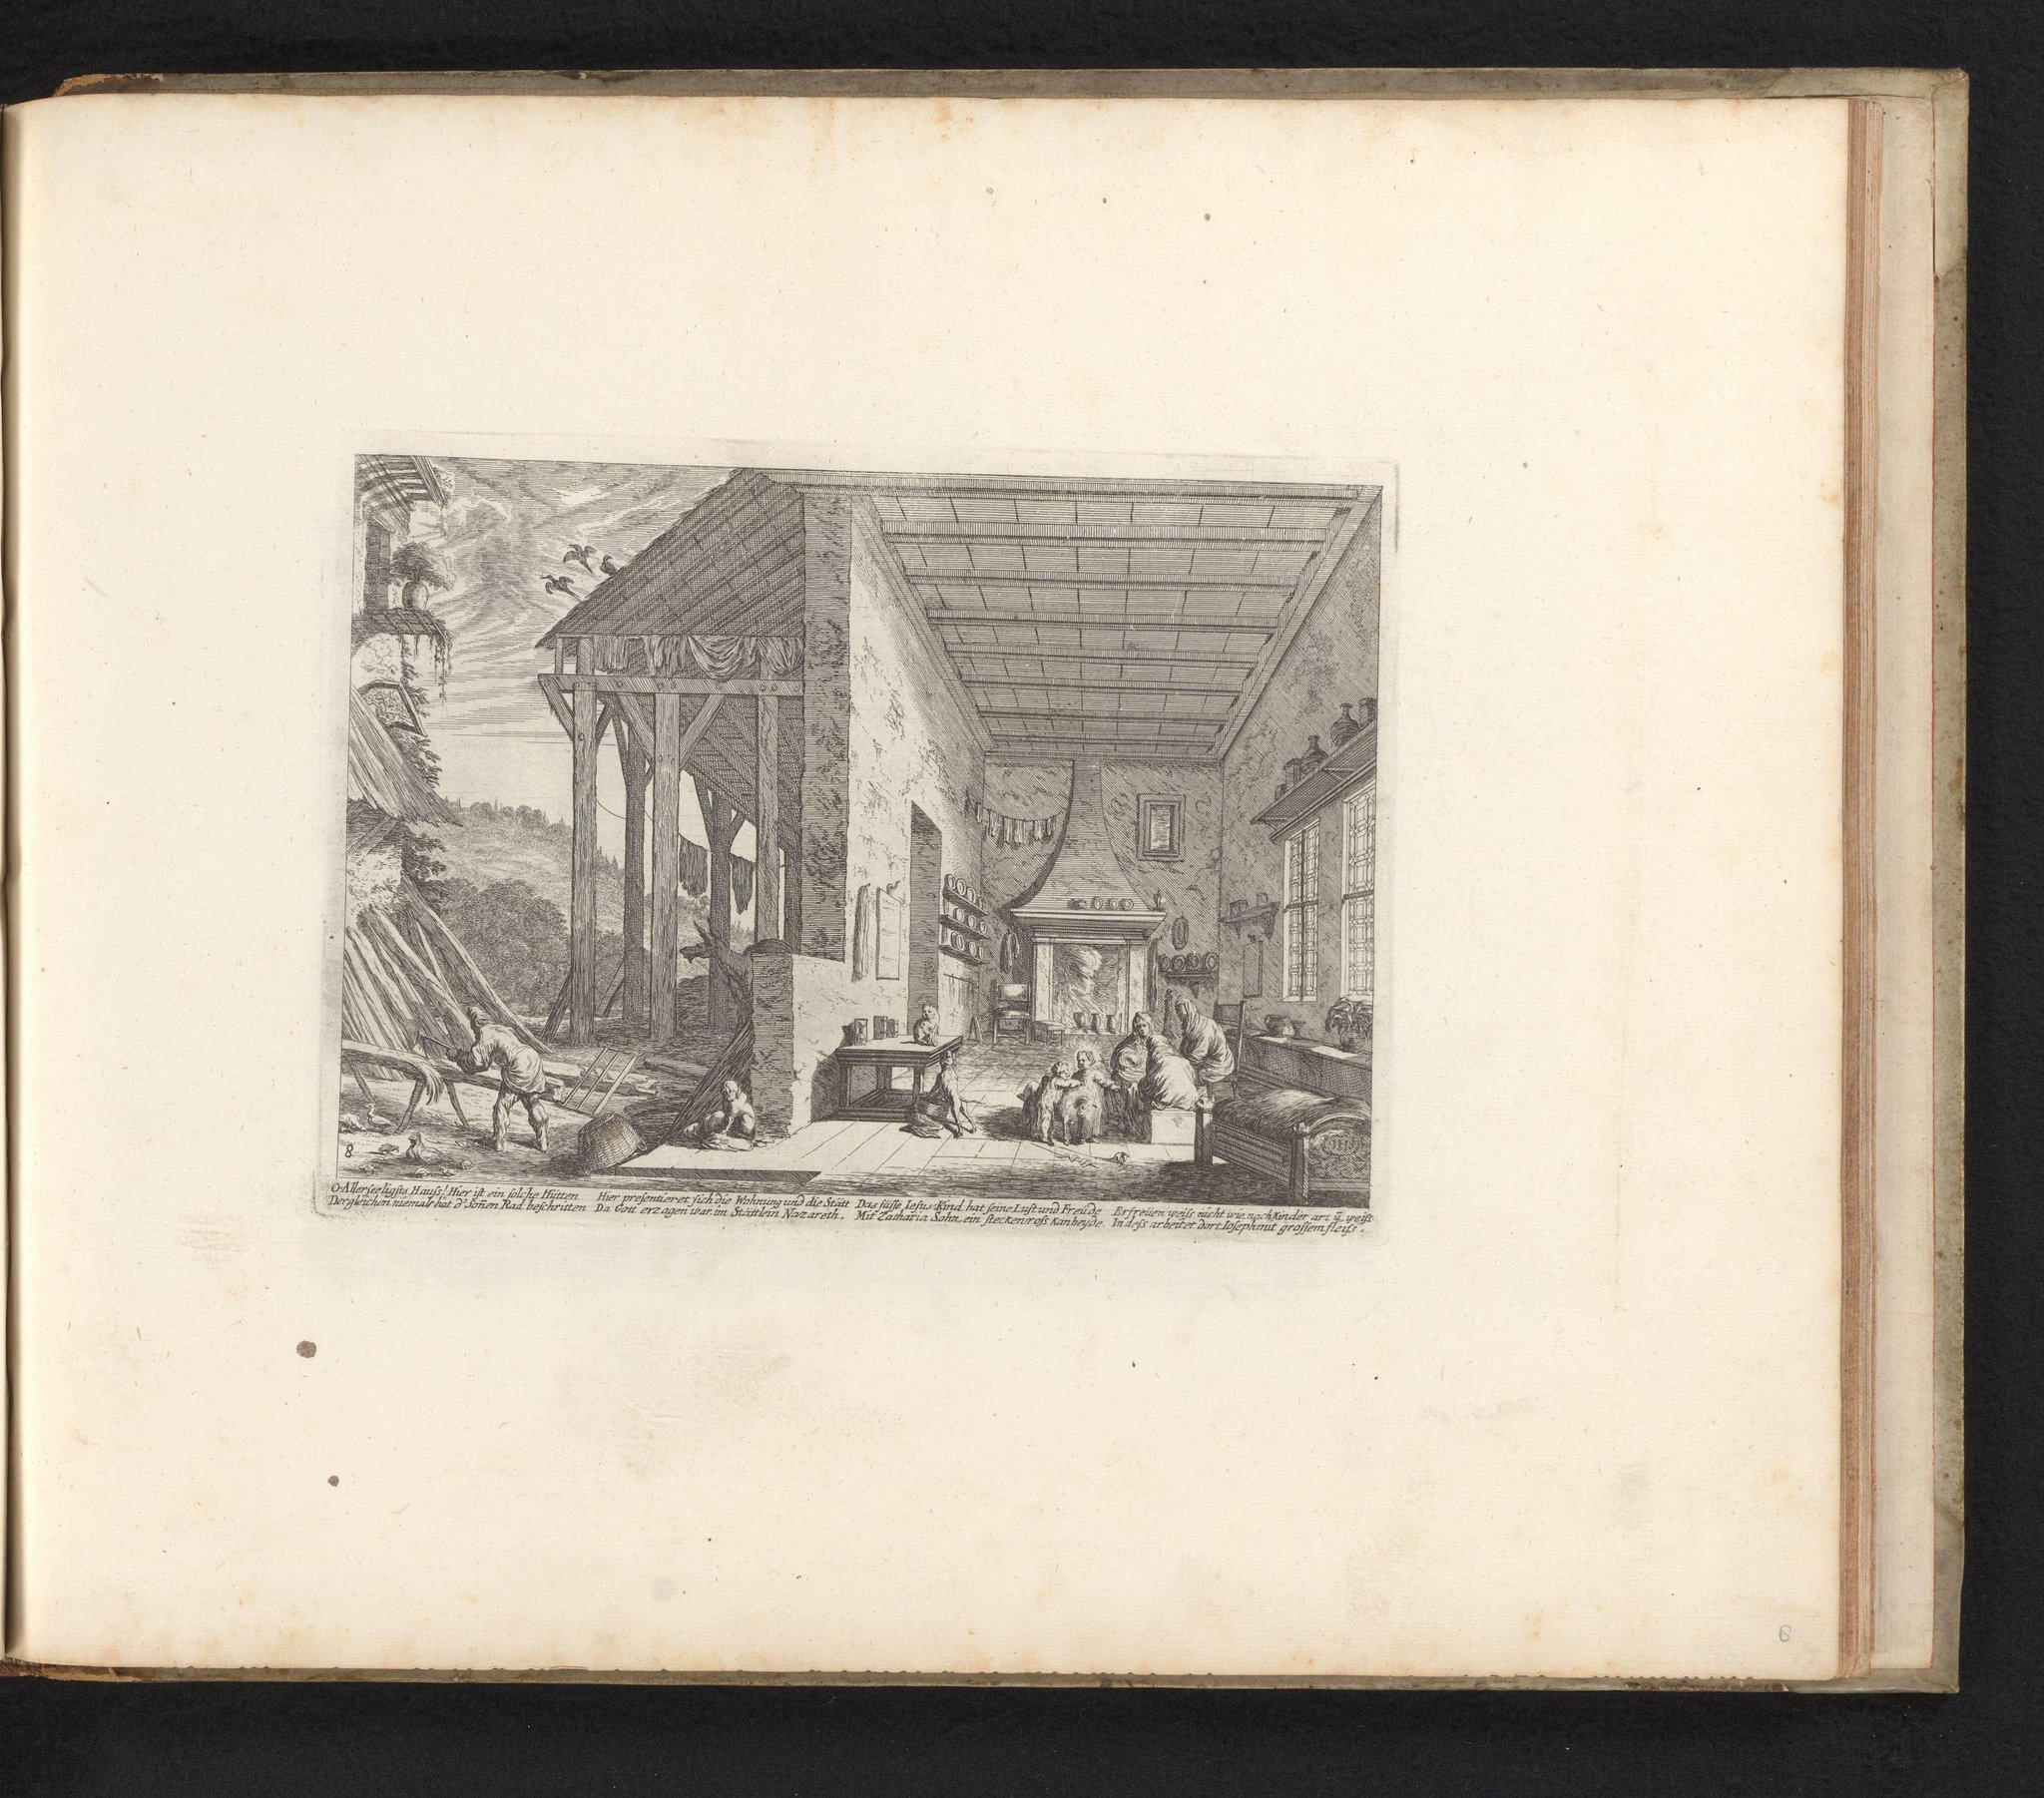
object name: album leaf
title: Heilige Familie in de timmermanswerkplaats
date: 1670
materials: paper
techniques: etching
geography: augsburg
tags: joseph with the christ-child (and mary) in his carpenter's workshop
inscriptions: collector's mark: Lugt 2228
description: Tekst in het Duits in de ondermarge. Linksonder genummerd: 8. Prent maakt deel uit van een album.